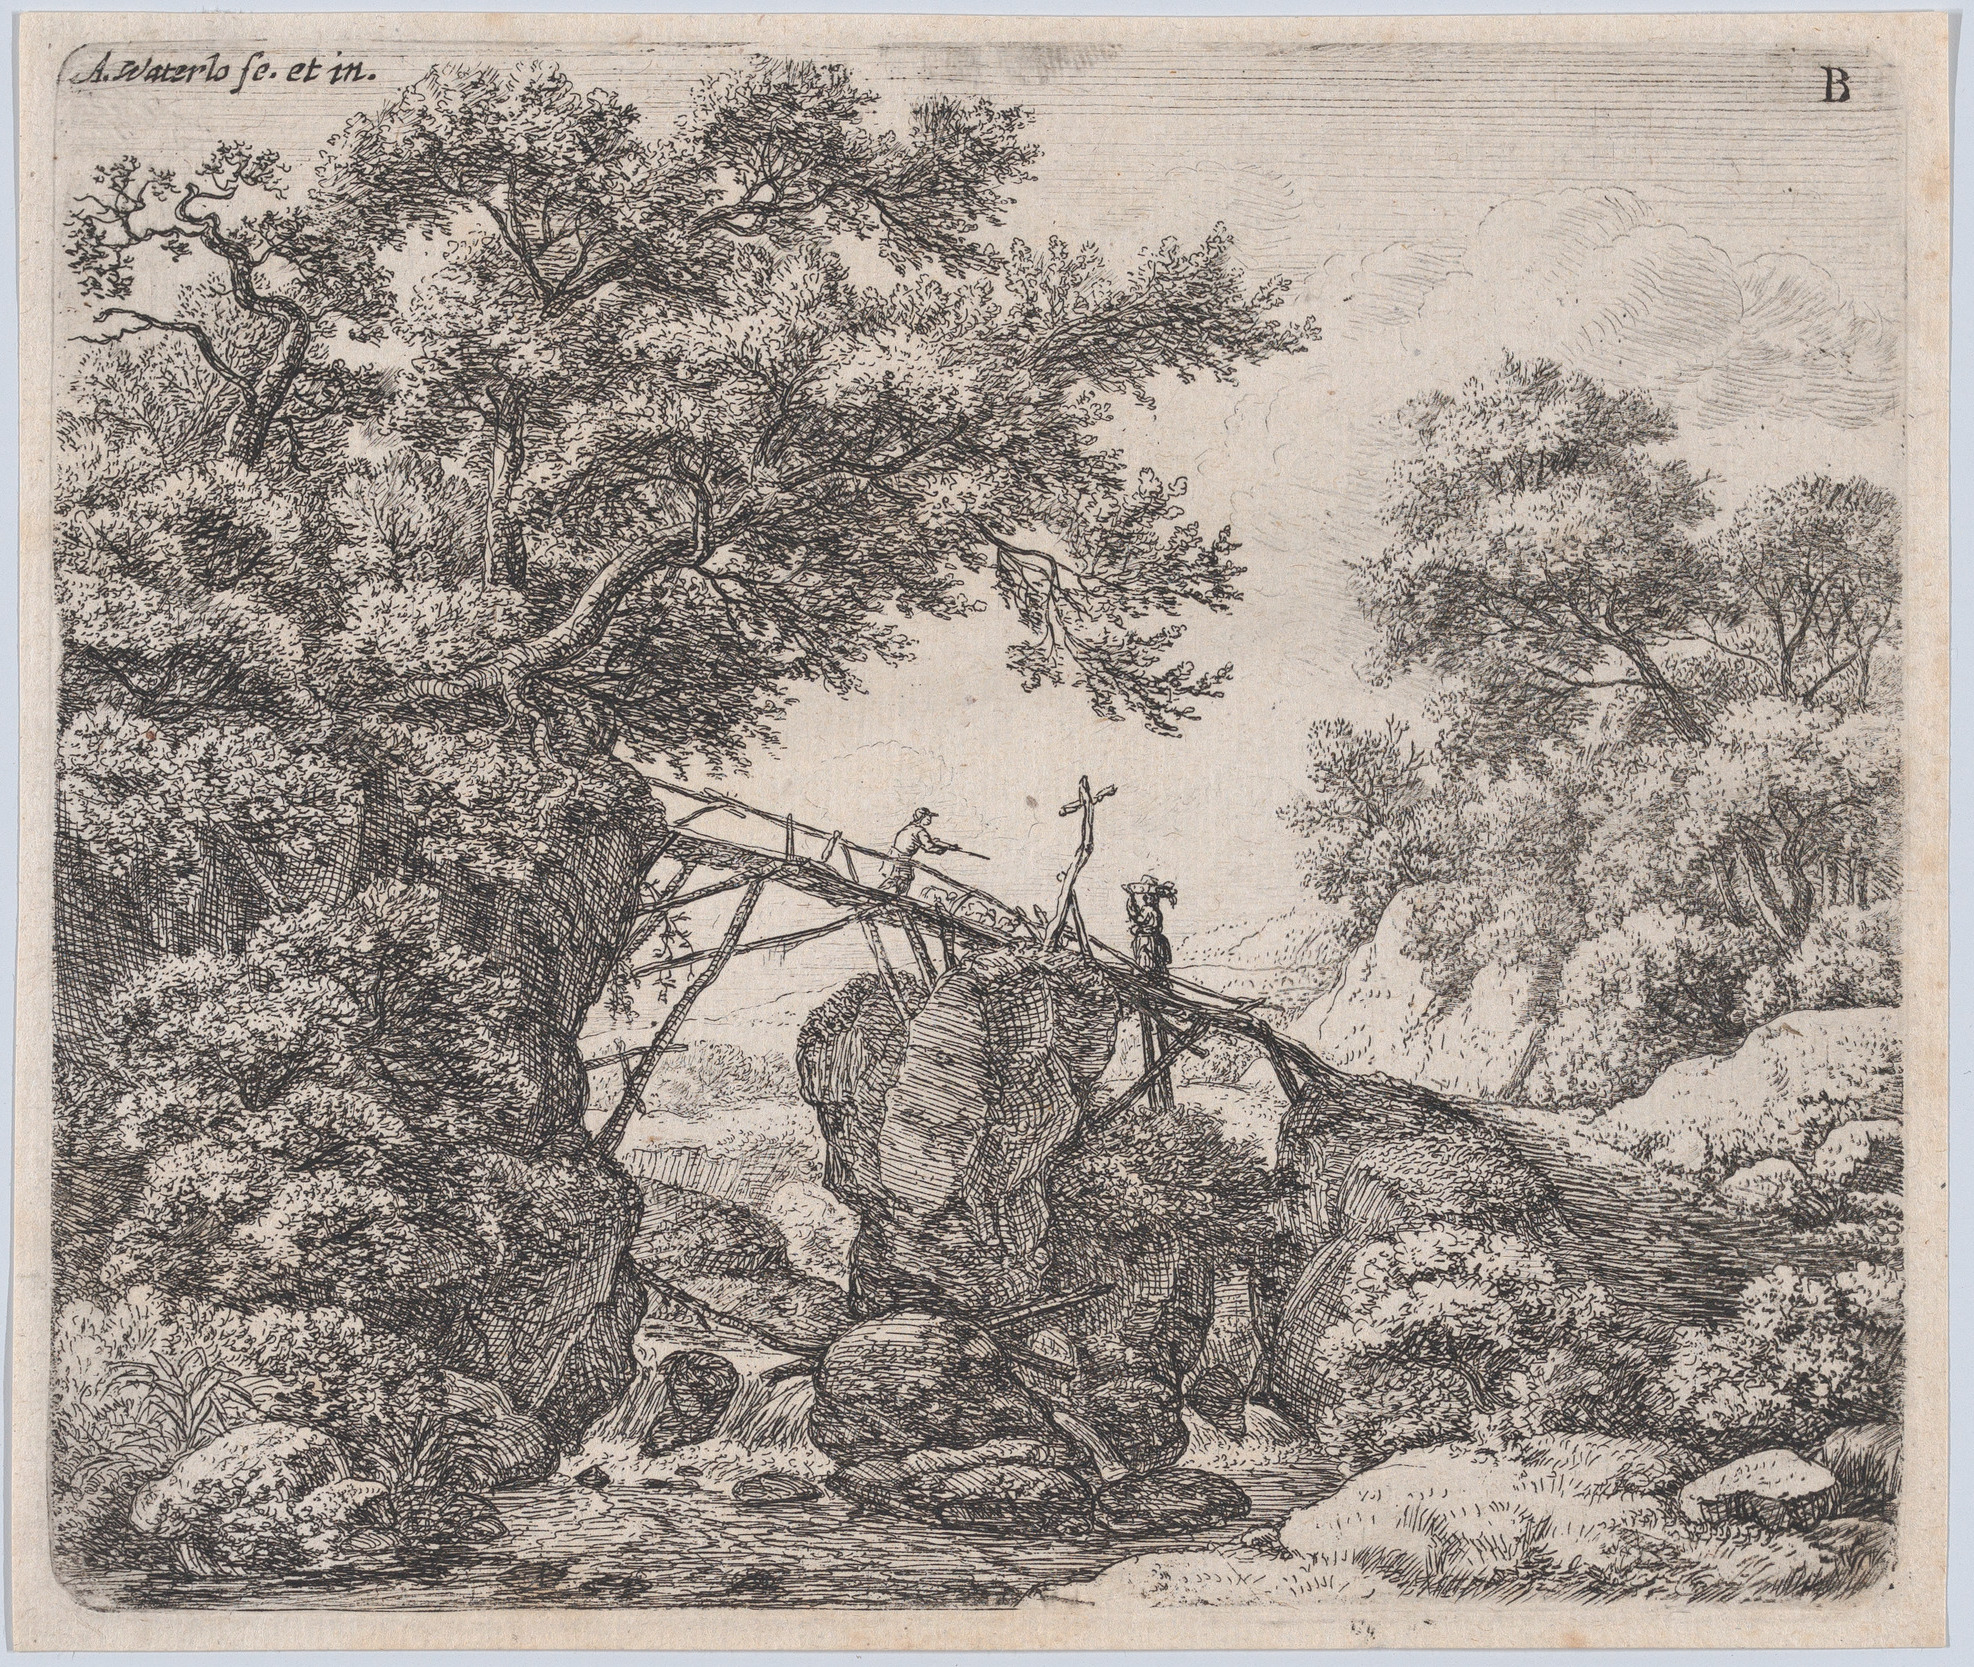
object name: print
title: The Small Sloping Bridge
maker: anthonie waterloo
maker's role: artist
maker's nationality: dutch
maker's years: 1609-1690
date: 1601-1700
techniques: etching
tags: bridges,landscapes